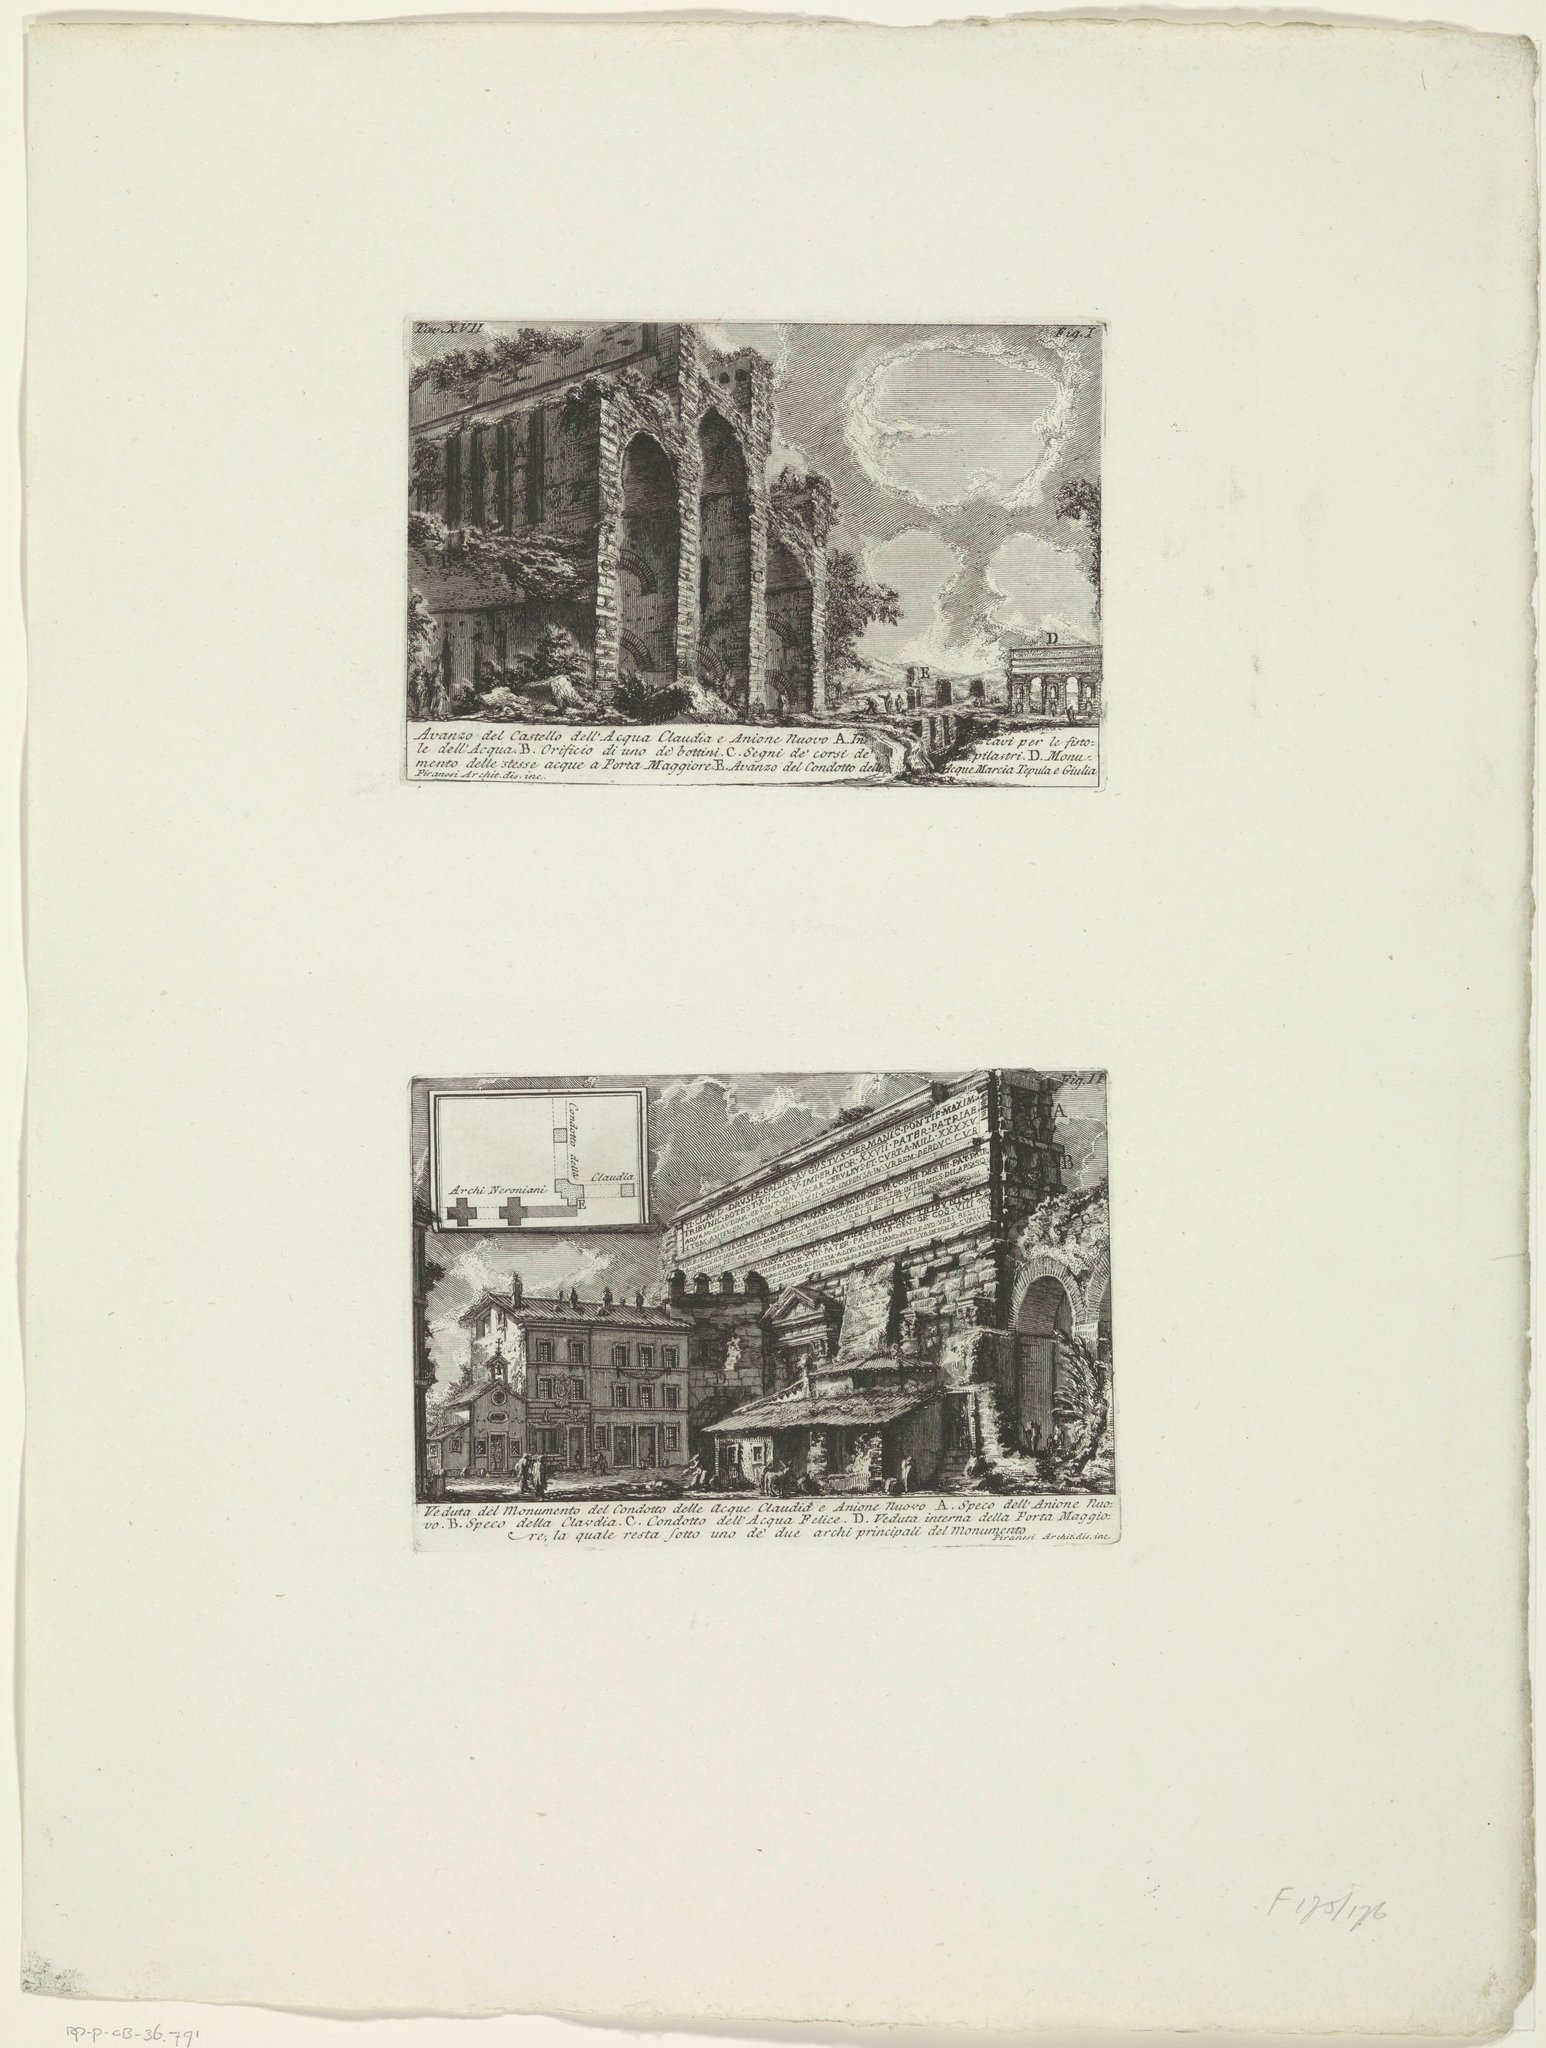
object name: print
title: Restanten van de Aqua Claudia en Aqua Anio Novus en de Porta Maggiore te Rome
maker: giovanni battista piranesi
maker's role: designer, draughtsman, print maker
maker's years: 1720-1778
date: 1756-1757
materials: paper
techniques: etching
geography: rome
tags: ruin of a building ~ architecture, landscape with bridge, viaduct or aqueduct, gate, entrance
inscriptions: collector's mark: Lugt 2228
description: Blad met twee voorstellingen van Romeinse bouwwerken. Boven: restanten van de boven elkaar gelegen aquaducten Aqua Claudia en Aqua Anio Novus. In de verte de stadspoort Porta Maggiore die onderdeel uitmaakte van de aquaducten. Genummerd linksboven: Tav. XVII. Genummerd rechtsboven: Fig. I. Titel en verklarende lijst met letters in ondermarge. Onder: de Porta Maggiore en restanten van de aquaducten Aqua Claudia en Aqua Anio Novus. Een plattegrond in een kader. Genummerd rechtsboven: Fig. II. Titel en verklarende lijst met letters in ondermarge.